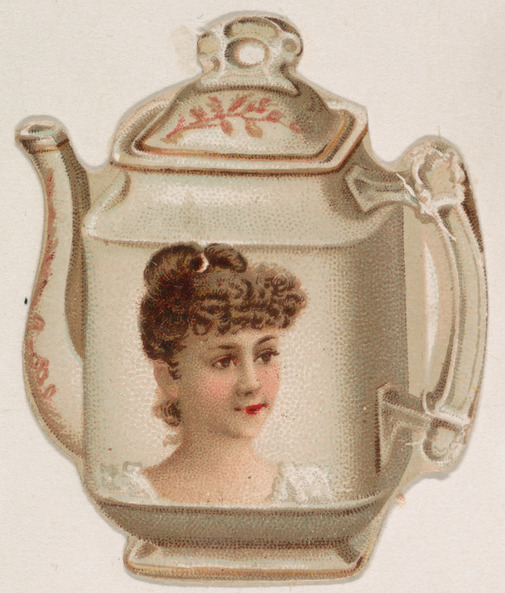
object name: print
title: Teapot, from the Novelties series (N228, Type 3) issued by Kinney Bros.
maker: kinney brothers tobacco company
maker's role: publisher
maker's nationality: american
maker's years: 1869-2011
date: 1889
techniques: color lithograph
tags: women,teapots